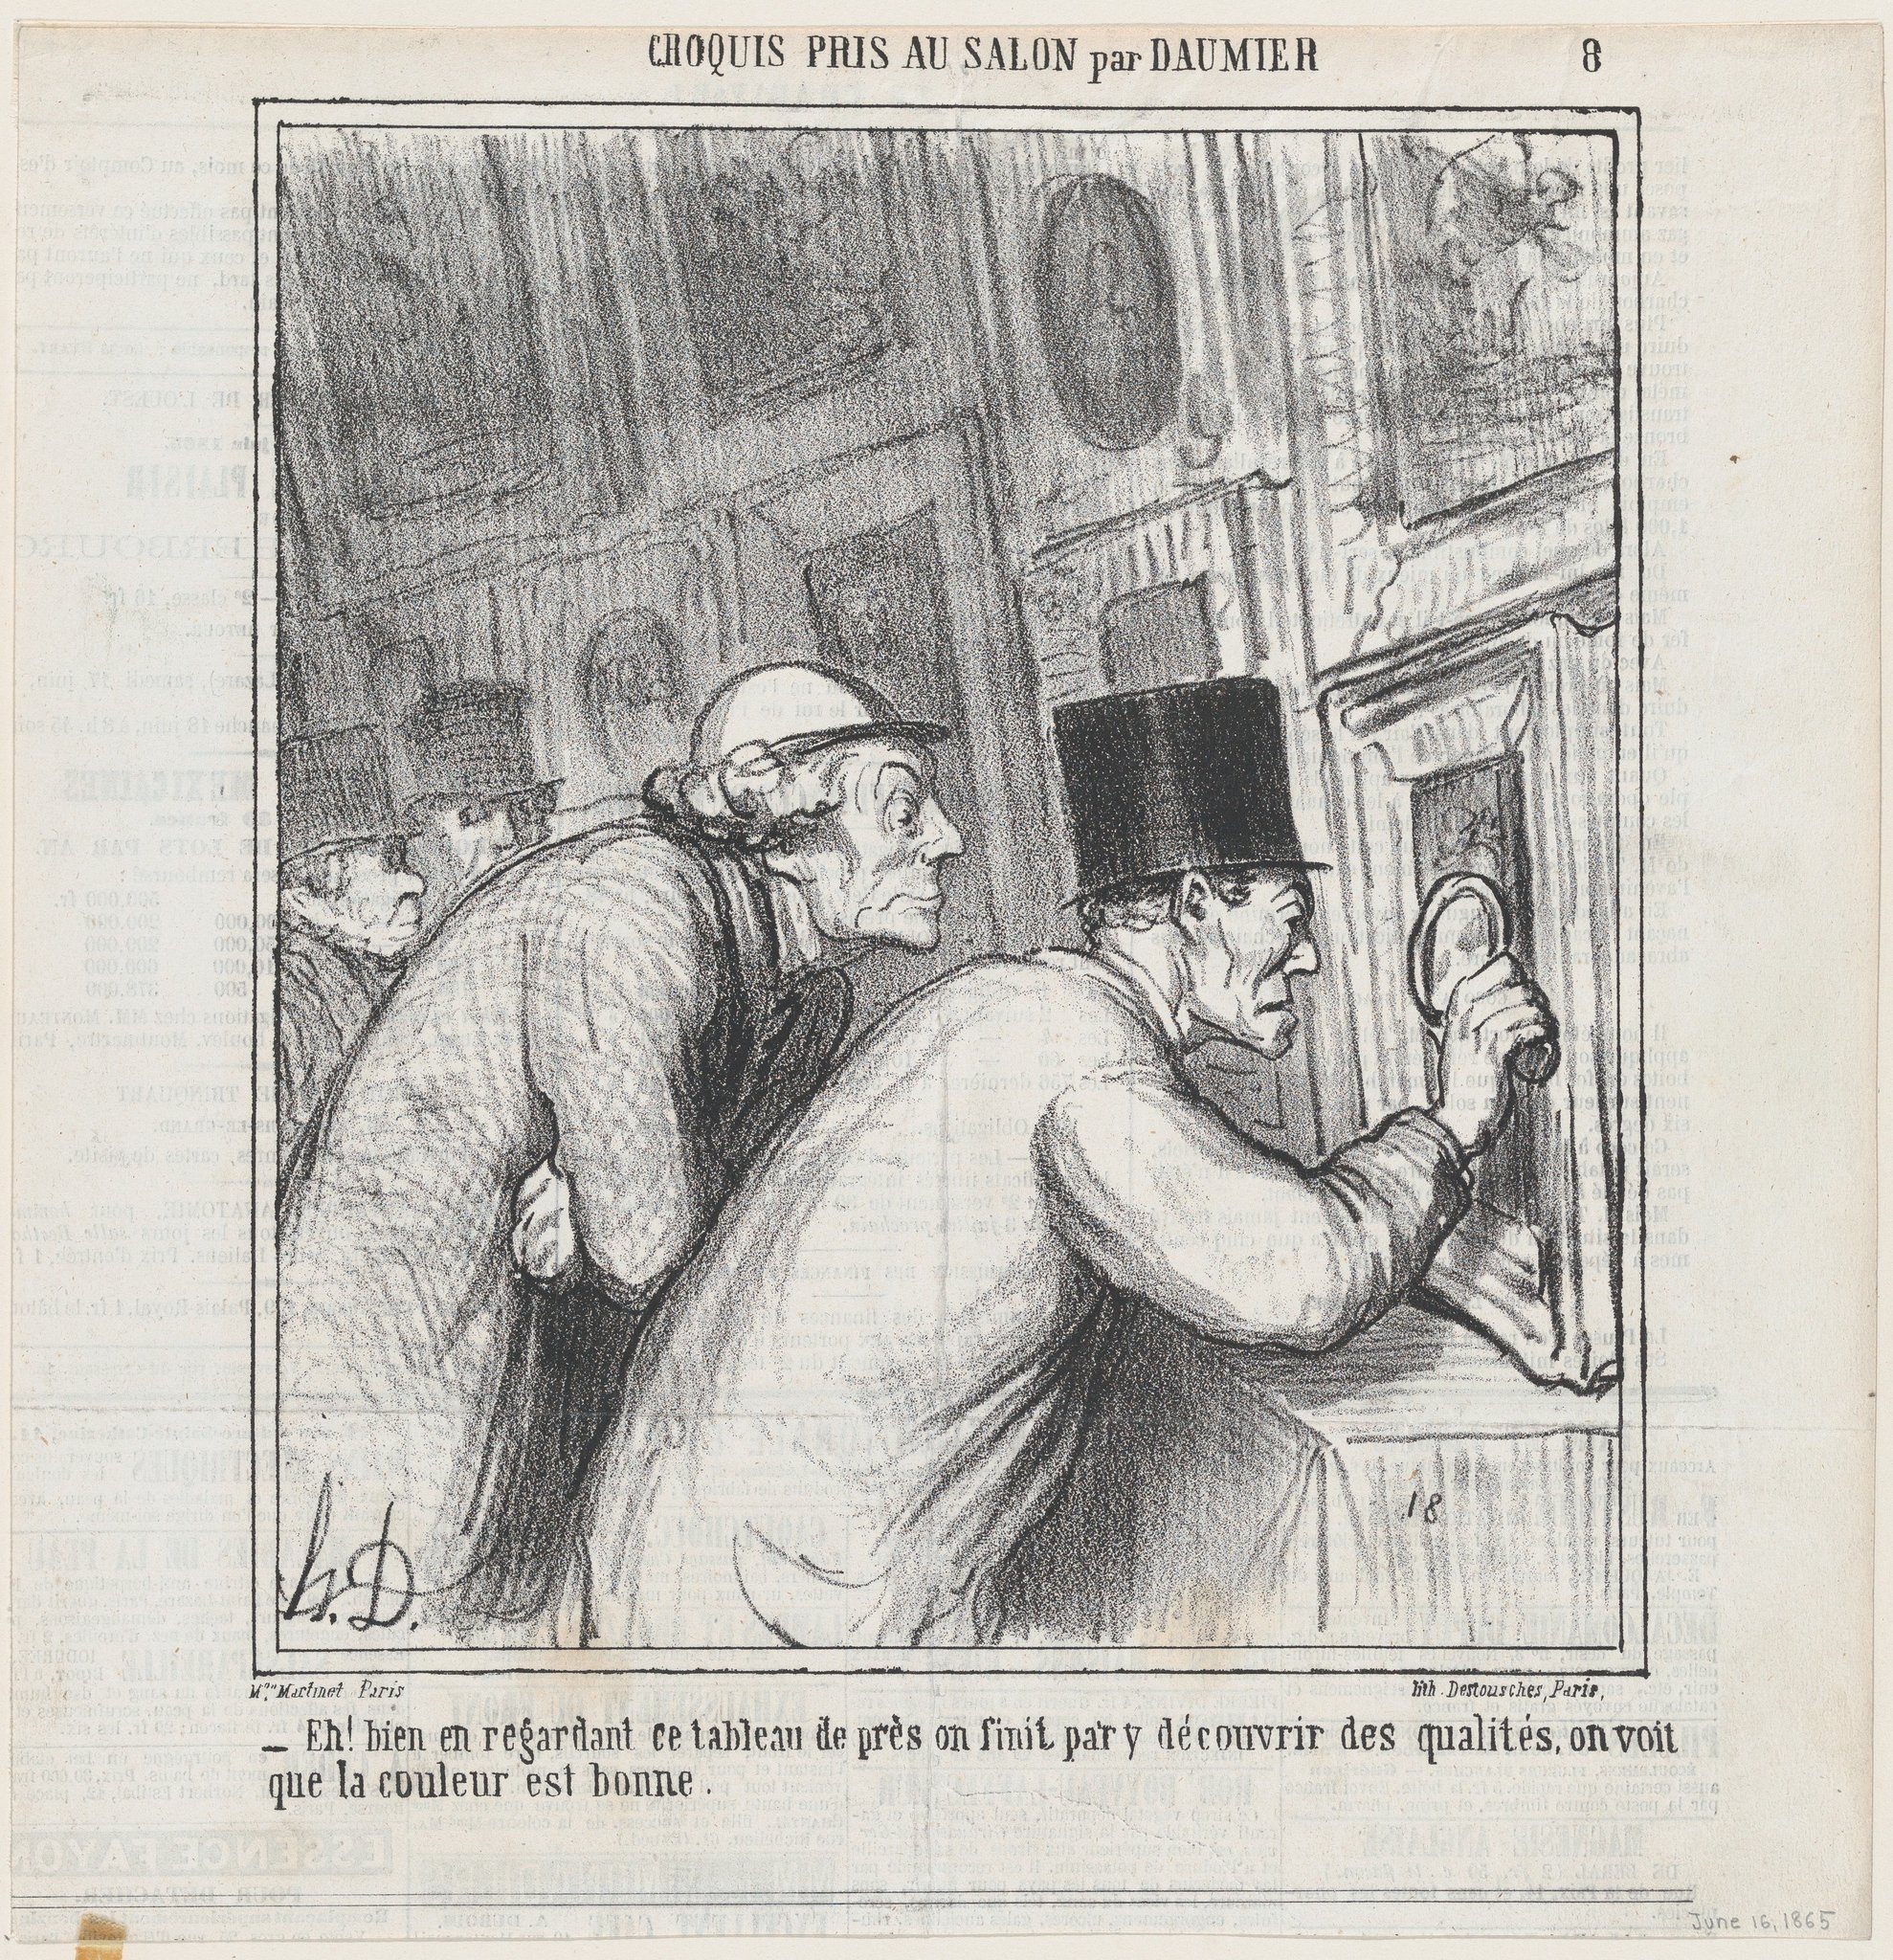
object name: print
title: Well, if you look very closely, you might end up finding some quality! The color seems to be good., from 'Sketches from the Salon,' published in Le Charivari, June 16, 1865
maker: honoré daumier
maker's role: artist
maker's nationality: french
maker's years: 1808-1879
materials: paper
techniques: lithograph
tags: men